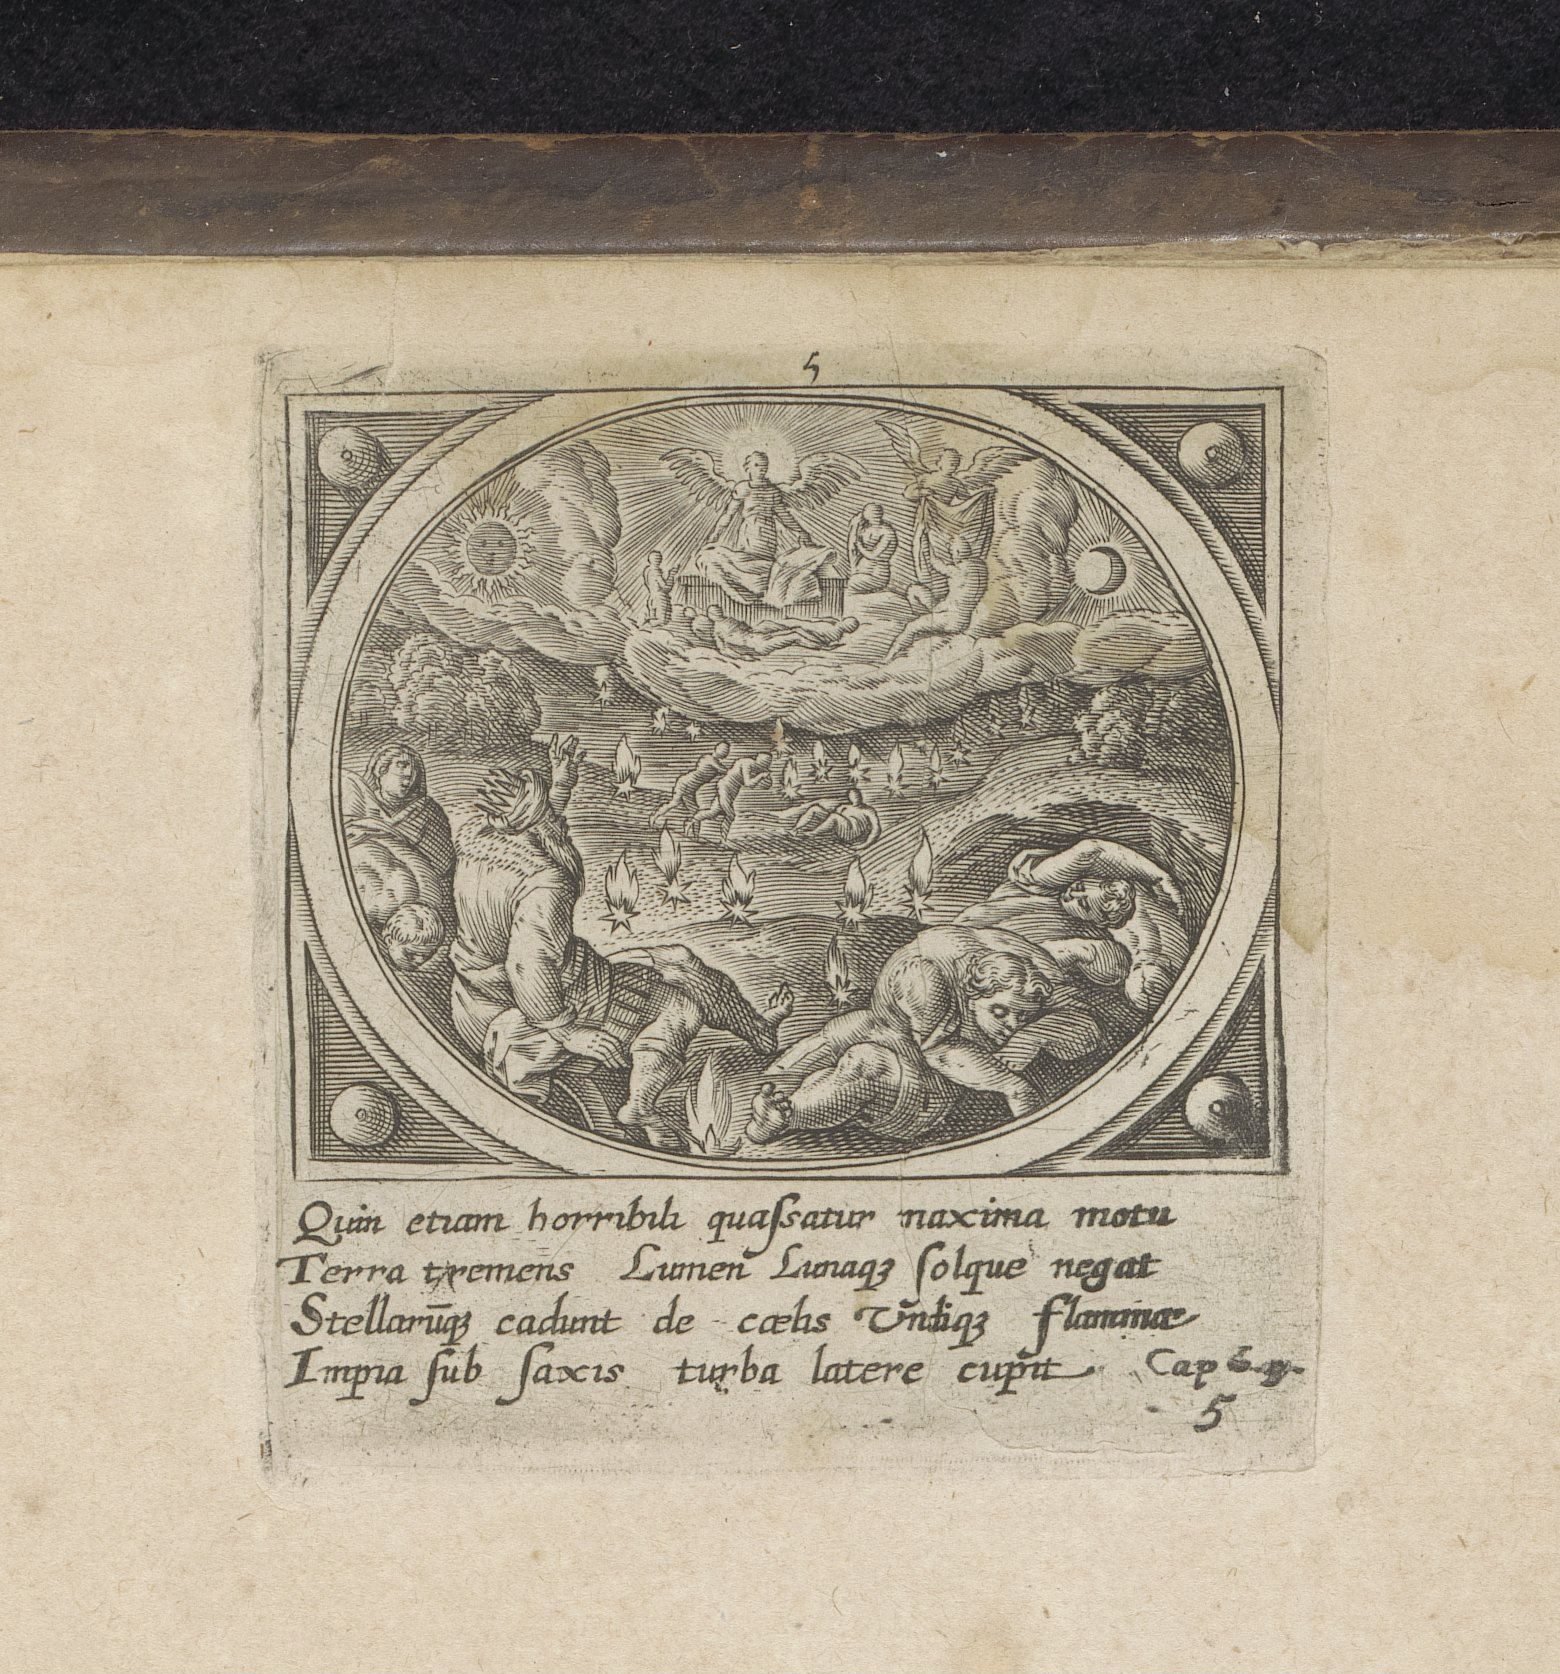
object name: print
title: Den Grooten Figuer-Bibel (...)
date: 1585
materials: paper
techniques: engraving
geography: amsterdam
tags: opening of the sixth seal: a great earthquake, the sun turns black, the moon red as blood, and the stars fall on earth; mankind hiding in caves, opening of the fifth seal: white robes are given to (the souls of) the martyrs under the altar (+ angel(s) floating in the air)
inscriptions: number: ‘20[8]’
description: Het openen van het vijfde zegel: bij een altaar staan de zielen, die allen witte kleren ontvangen. Daaronder het openen van het zesde zegel: brandende sterren vallen op aarde na een aardbeving. Onder de voorstelling een verwijzing in het Latijn naar de Bijbeltekst in Op. 6. Deze prent maakt deel uit van een album.